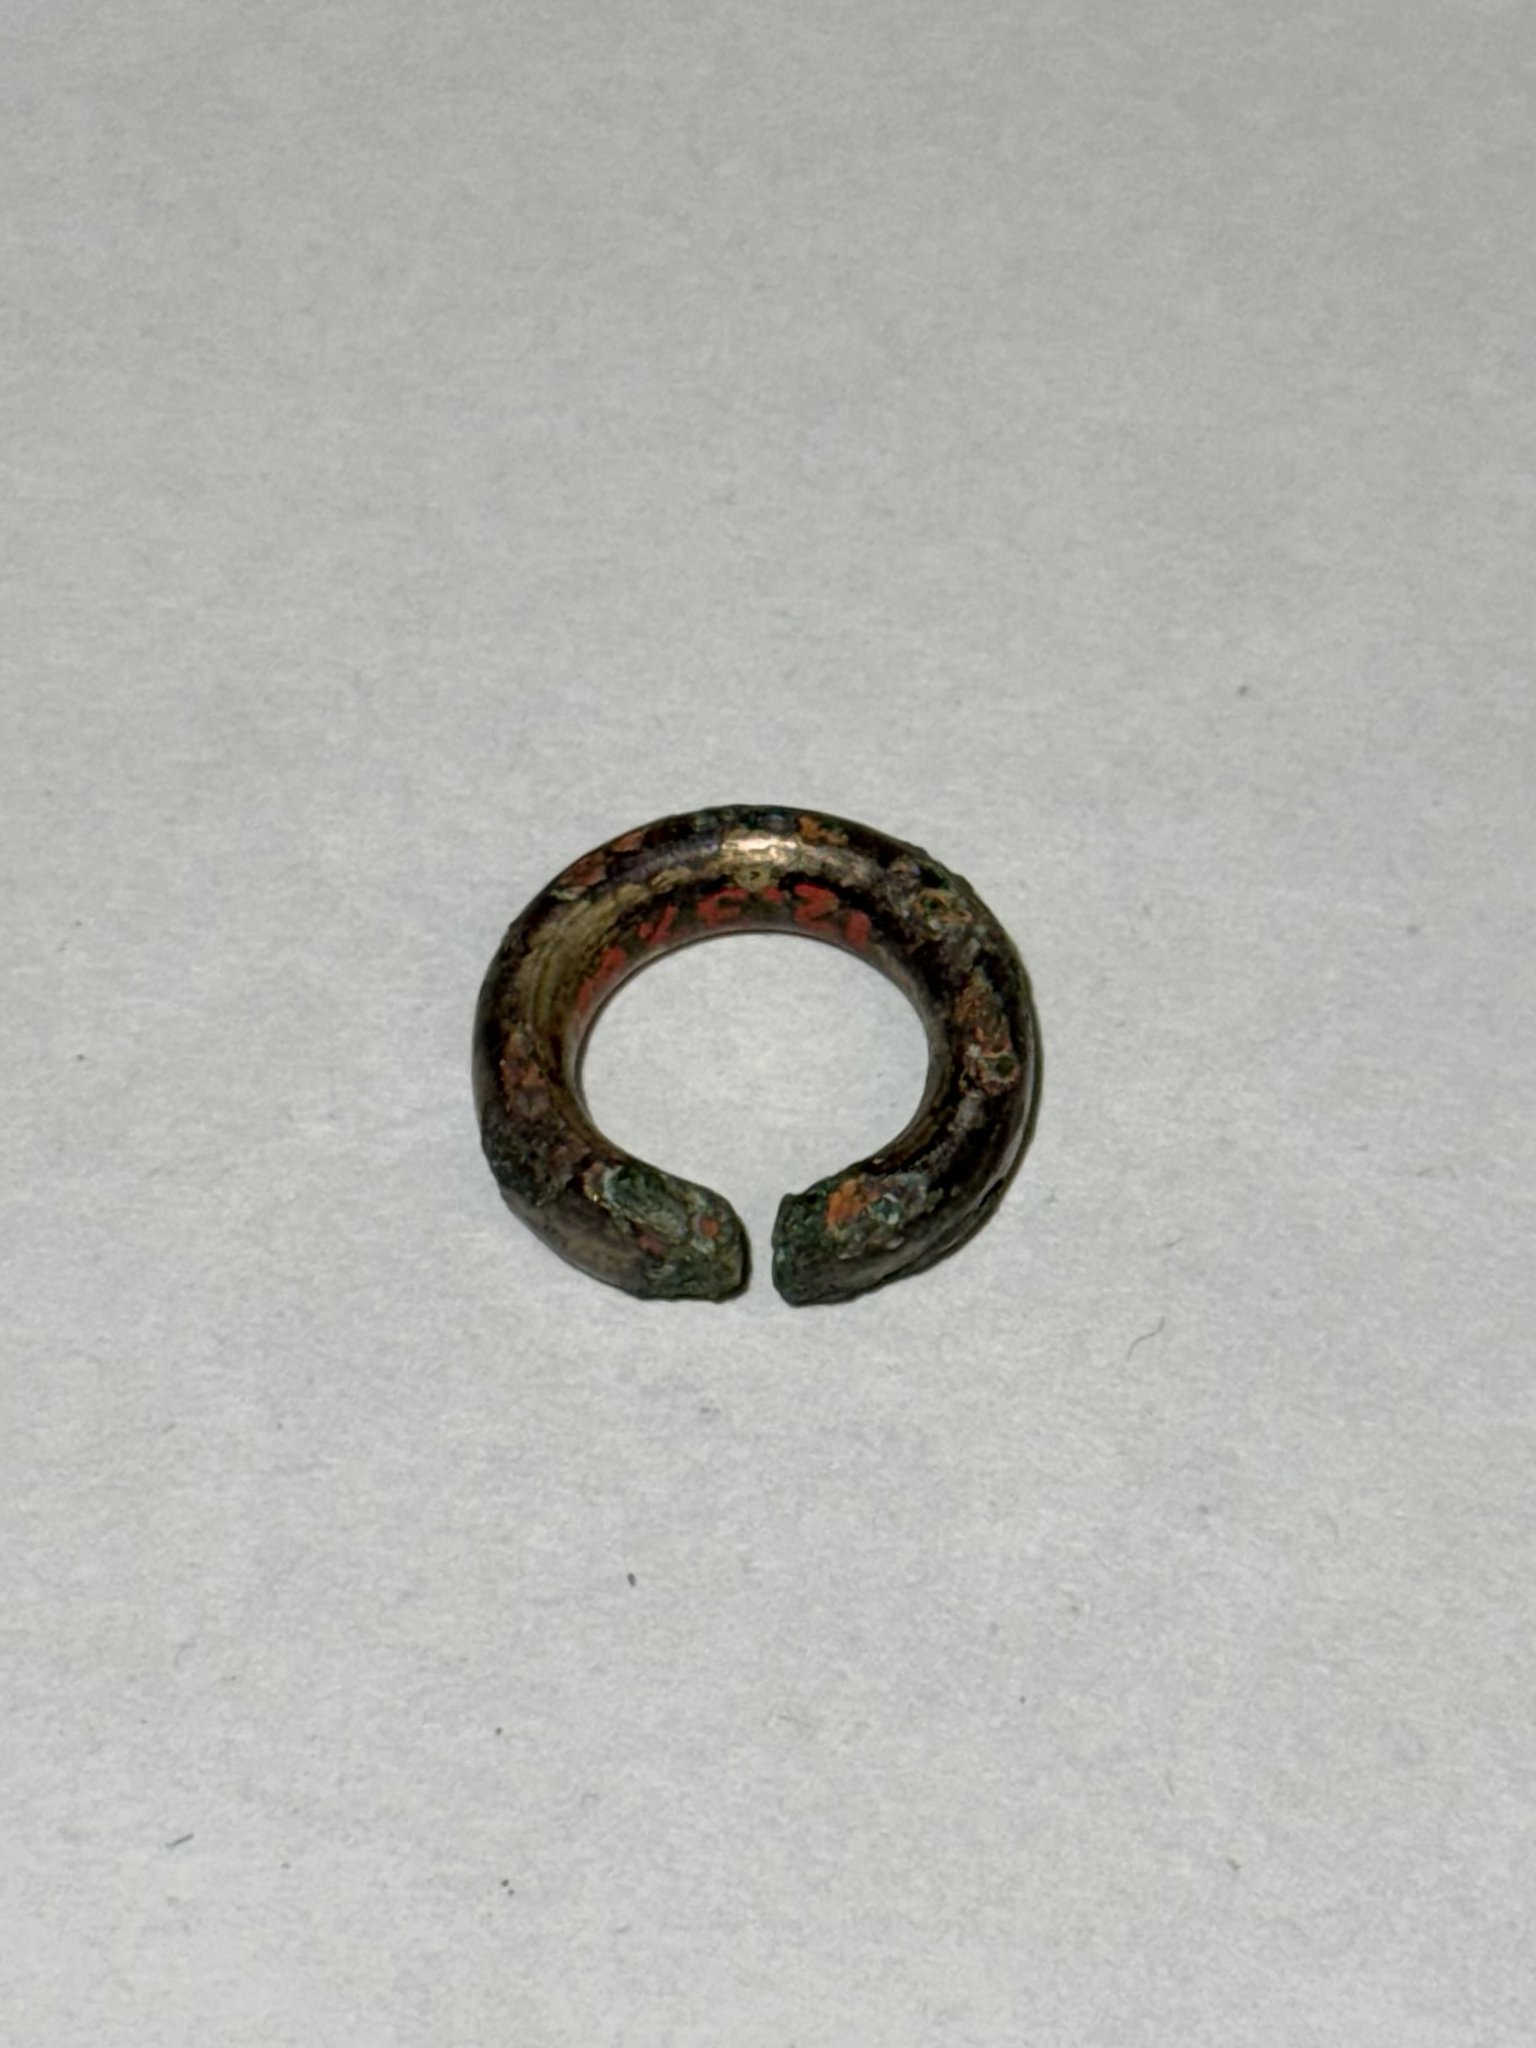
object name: earring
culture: japanese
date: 601-700